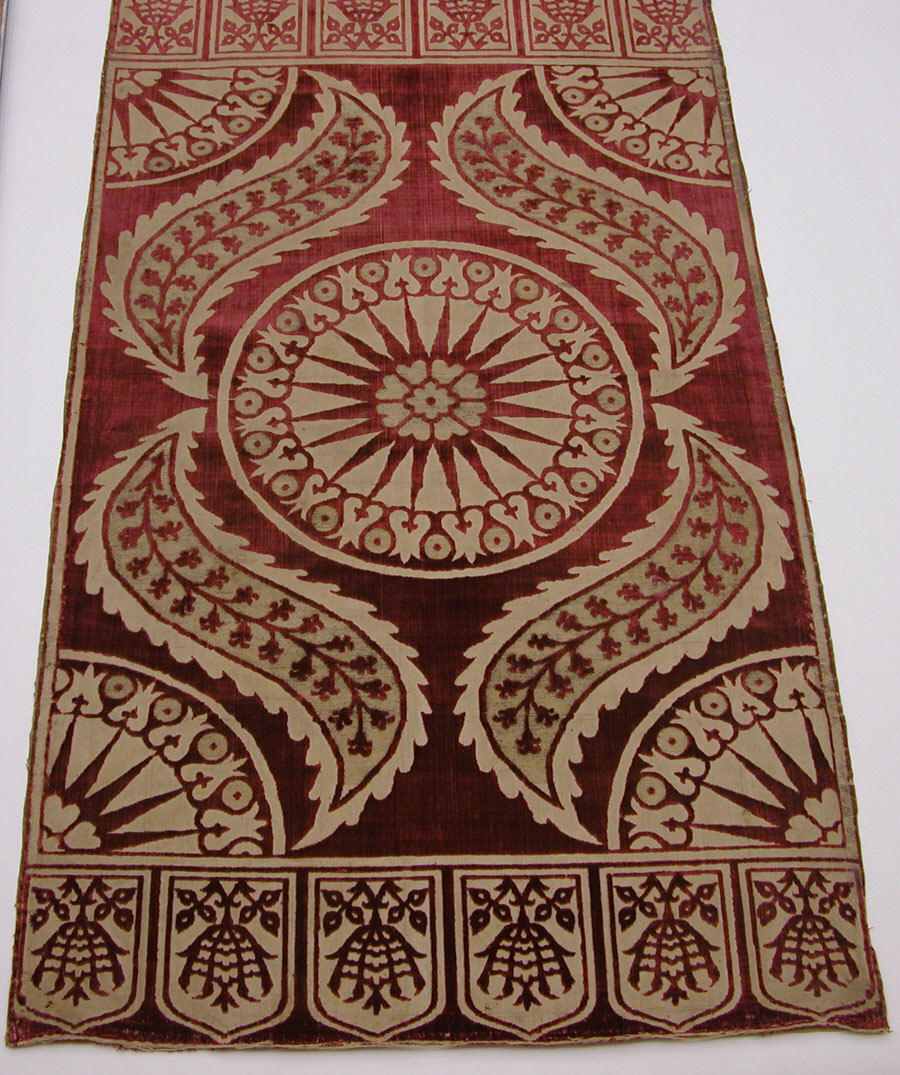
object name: cushion cover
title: Cushion Cover (Yastik)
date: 1601-1700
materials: cotton, metal thread, silk, velvet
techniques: brocade, cutting, voiding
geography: turkey